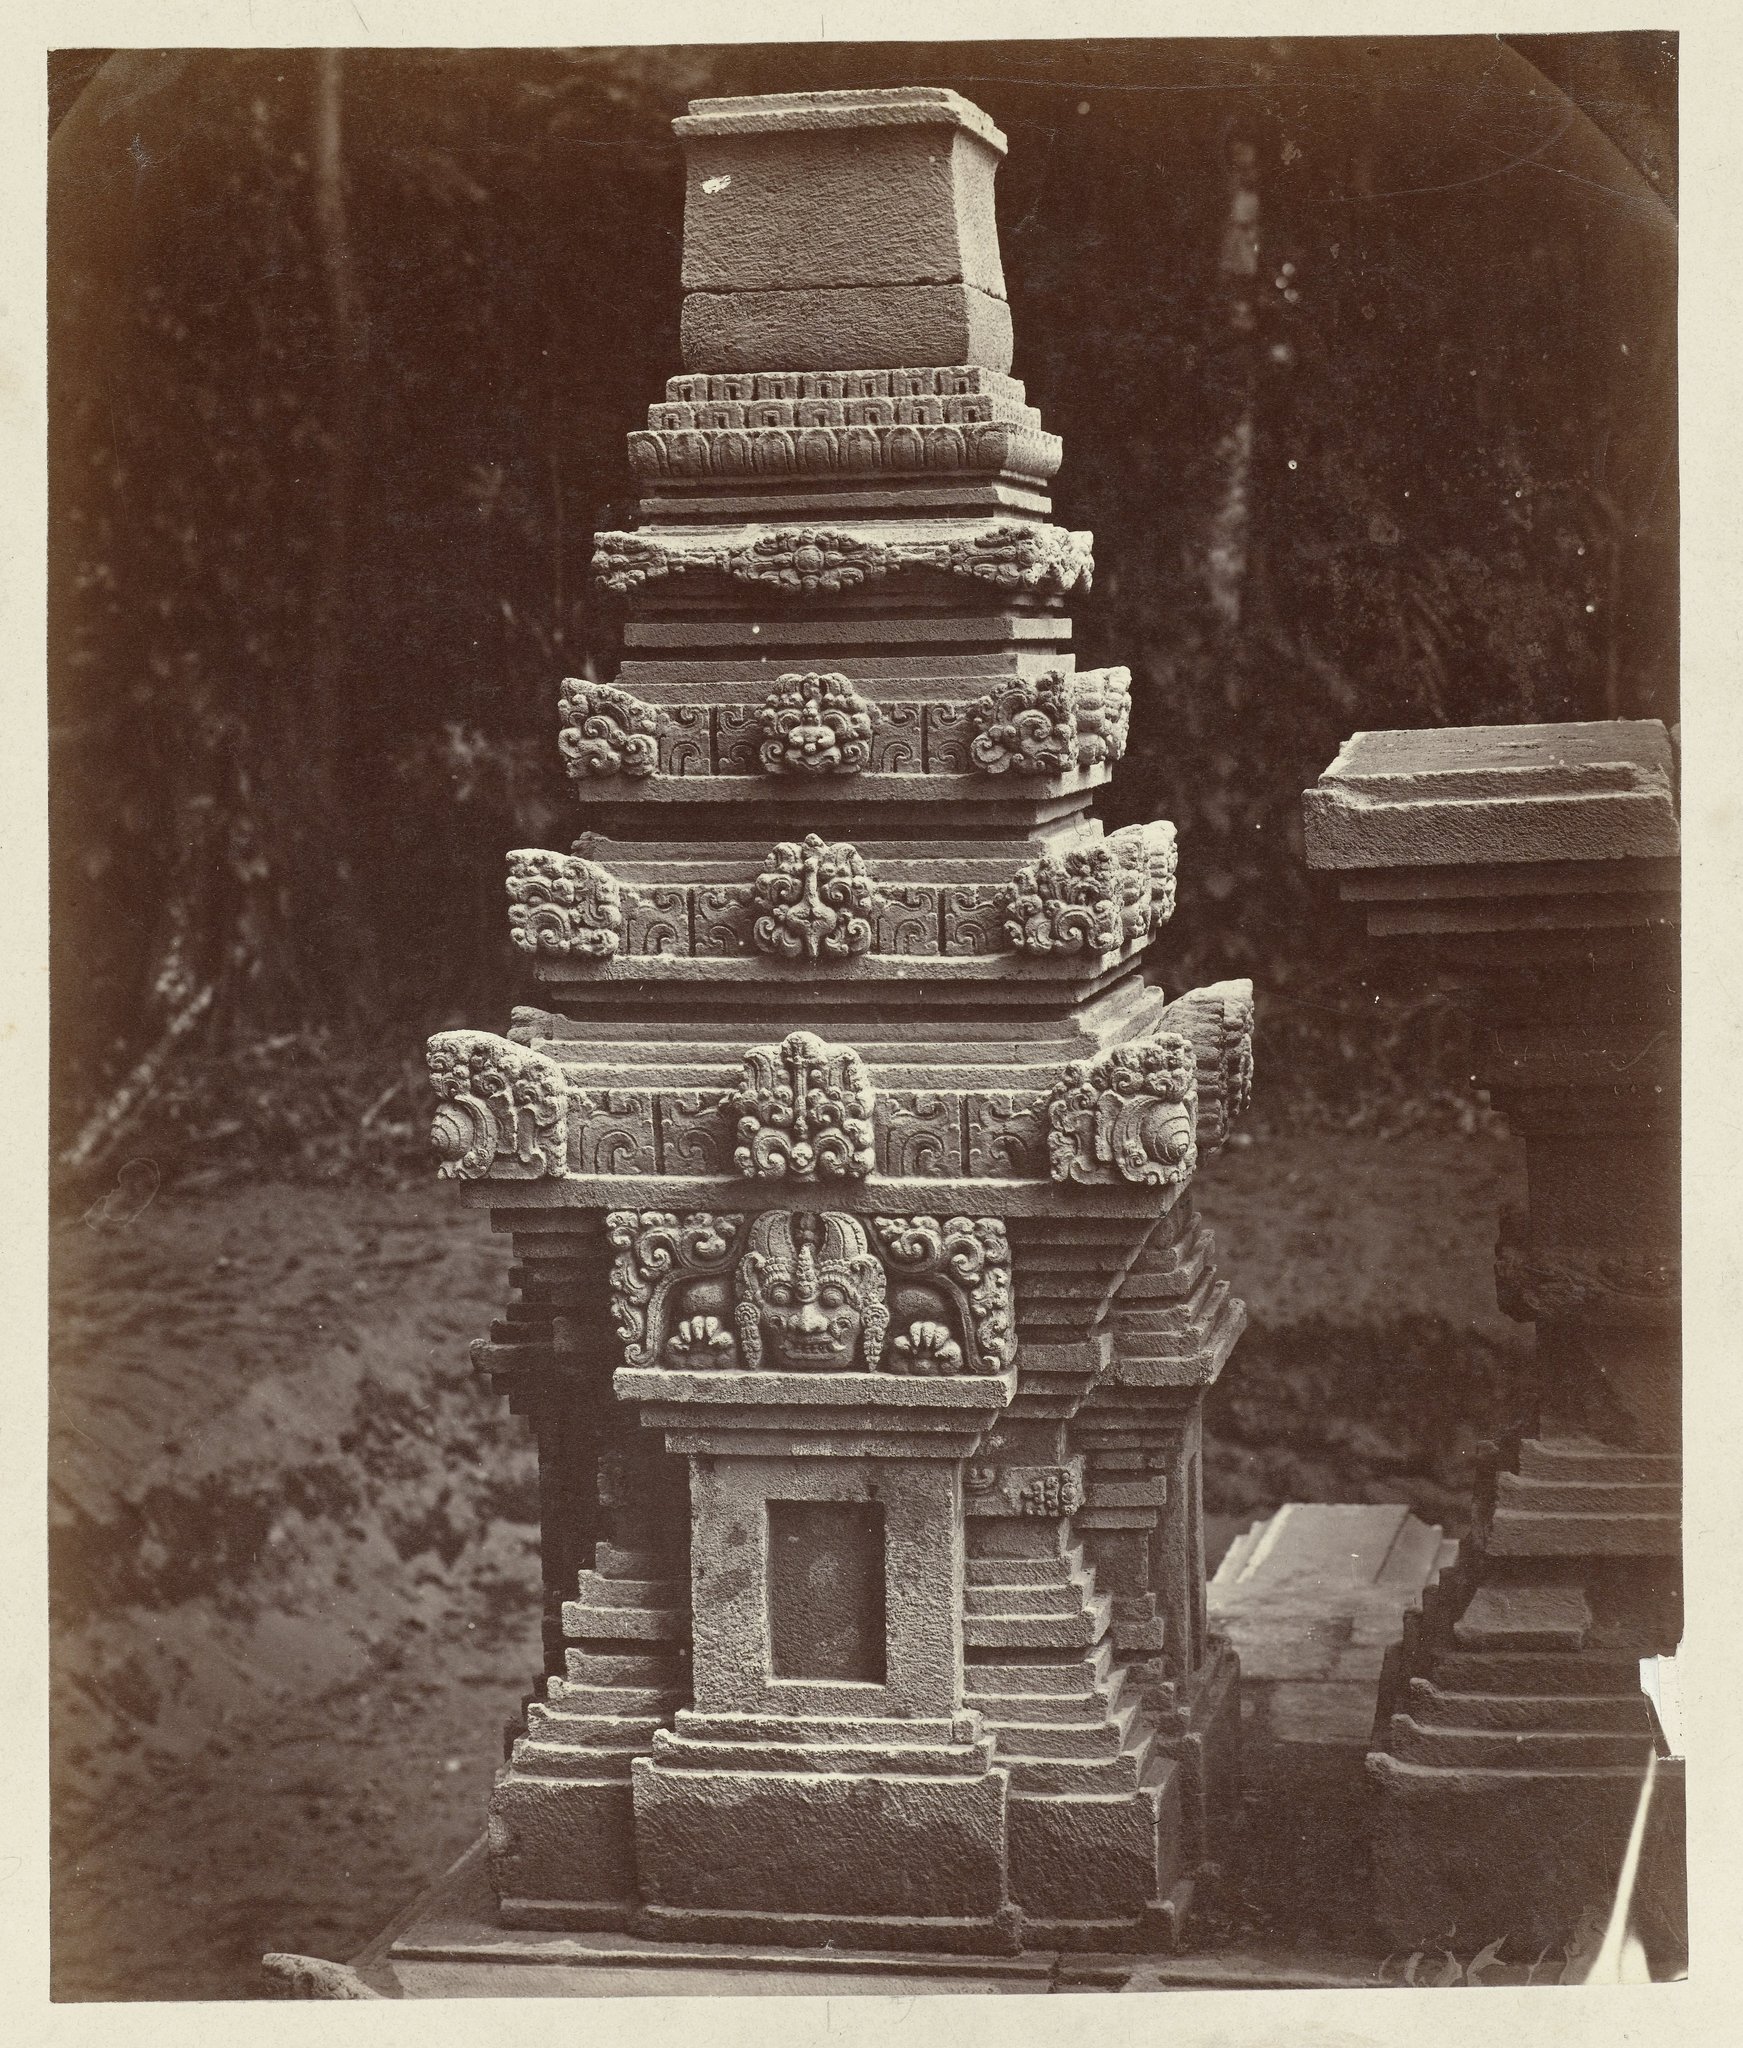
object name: photograph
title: Candi Papoh/Kotes, platform miniature temple with kalamukha ornaments, rear view. Gandusari, Blitar district, East Java province, 13th-14th century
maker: isidore kinsbergen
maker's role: fotograaf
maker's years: 1821-1905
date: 1807-1867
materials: cardboard, paper, photographic support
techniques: albumen print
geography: java